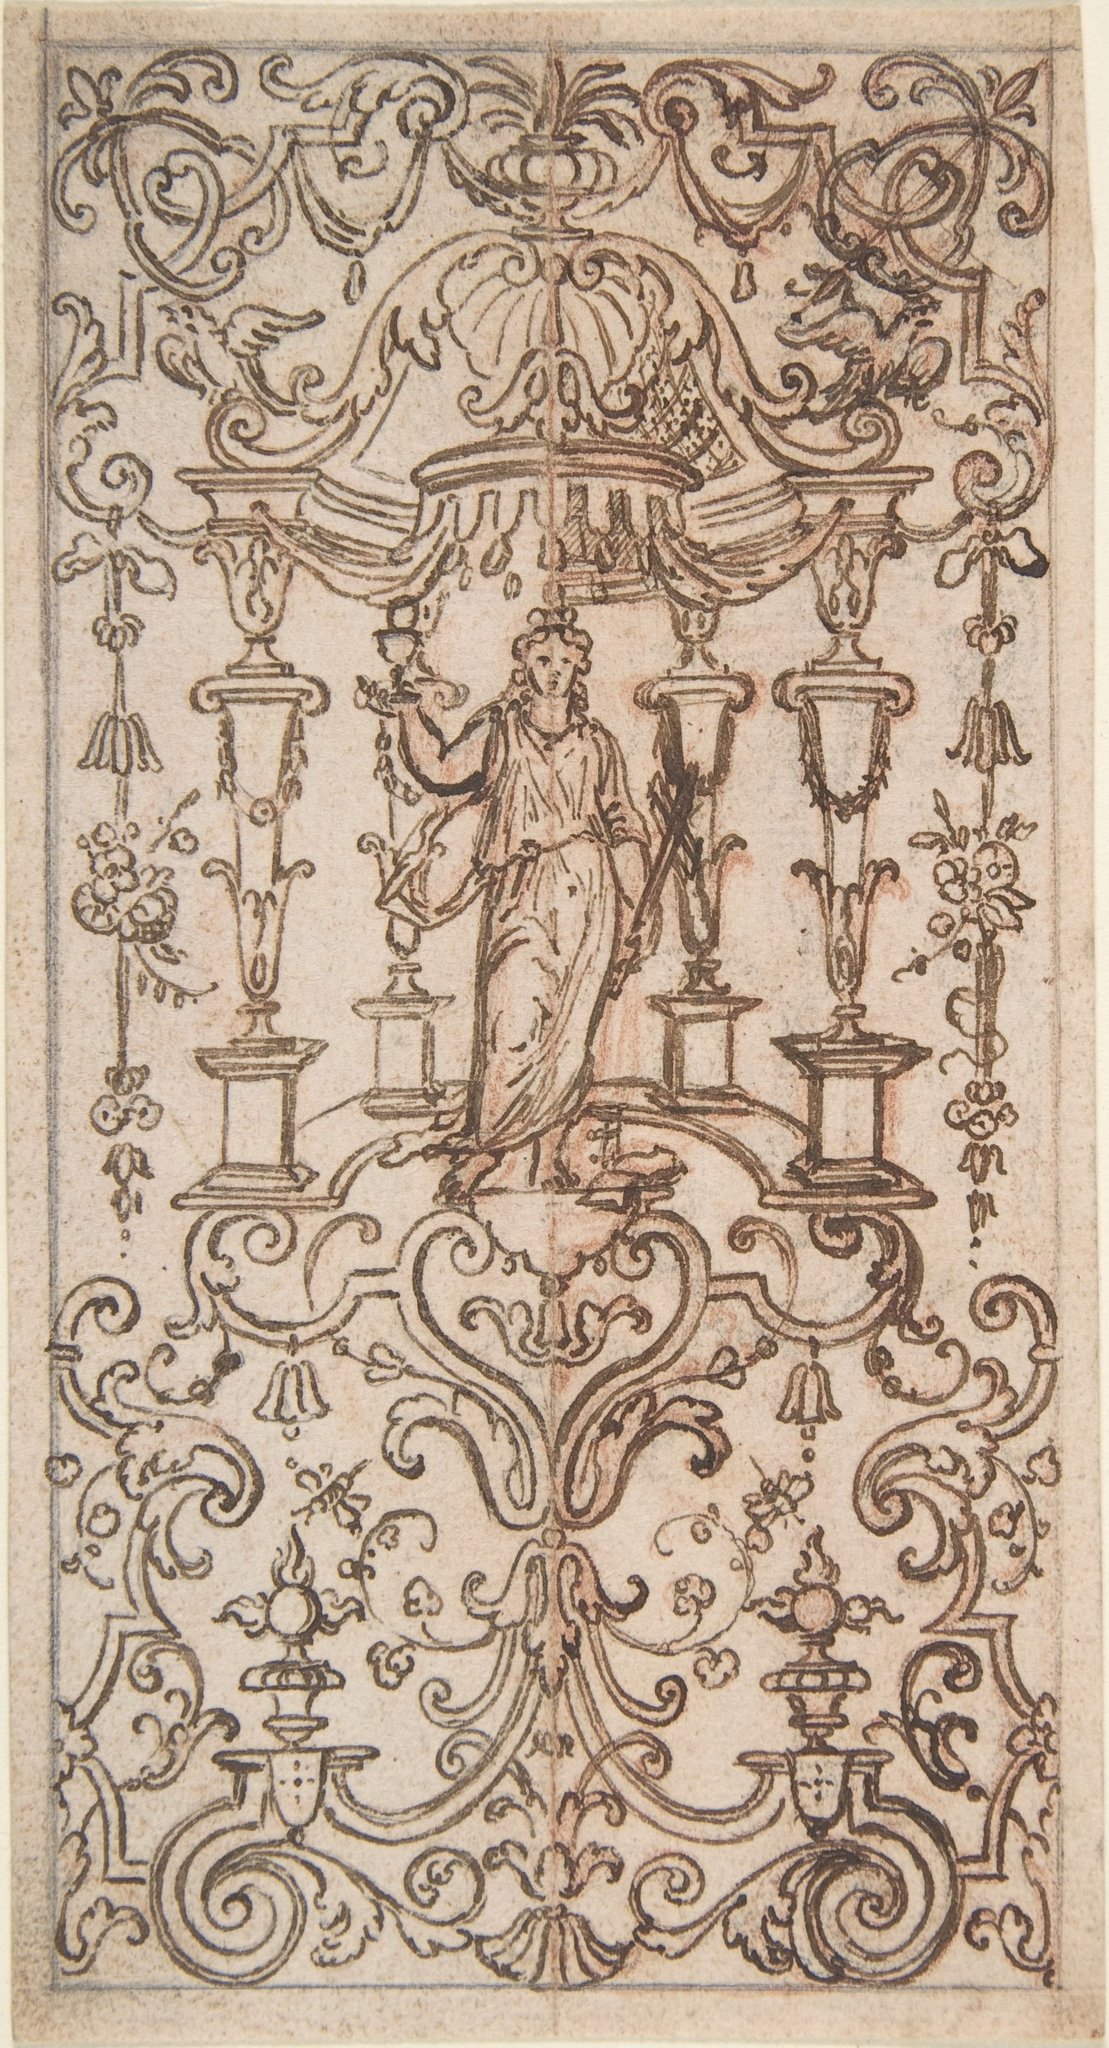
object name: drawing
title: Panel of Ornament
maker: anonymous, french, 17th century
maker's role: artist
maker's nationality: french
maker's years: 1600-1700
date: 1601-1700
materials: chalk, ink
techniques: pen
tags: caryatids,ornament,cross